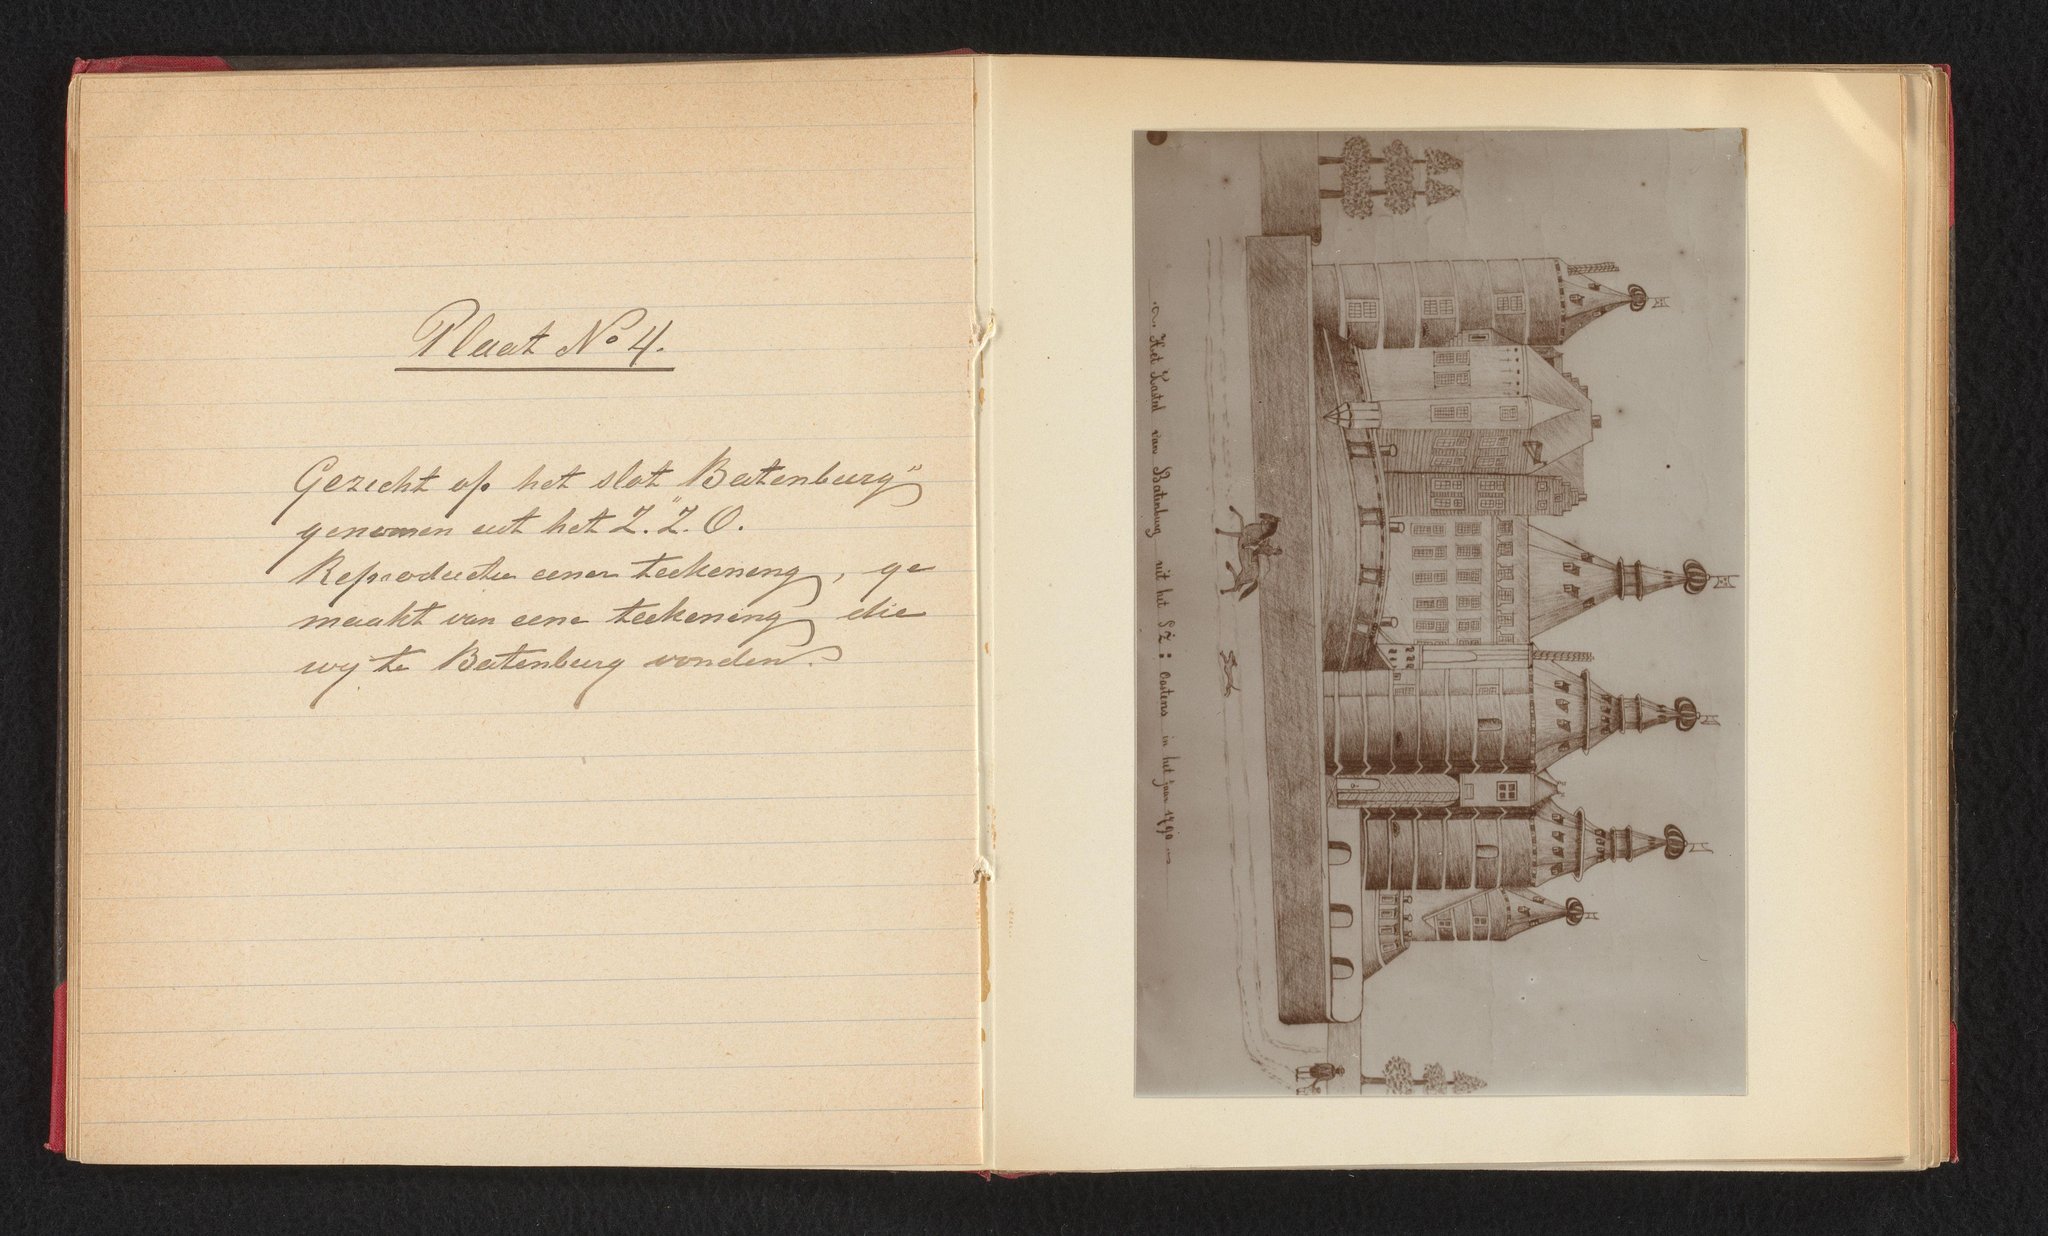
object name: page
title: Het Kasteel van Batenburg uit het SZ: Oostens in het jaar 1790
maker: benjamin charlé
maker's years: 1845-1925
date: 1902-1907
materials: paper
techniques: collodion silver print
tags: castle